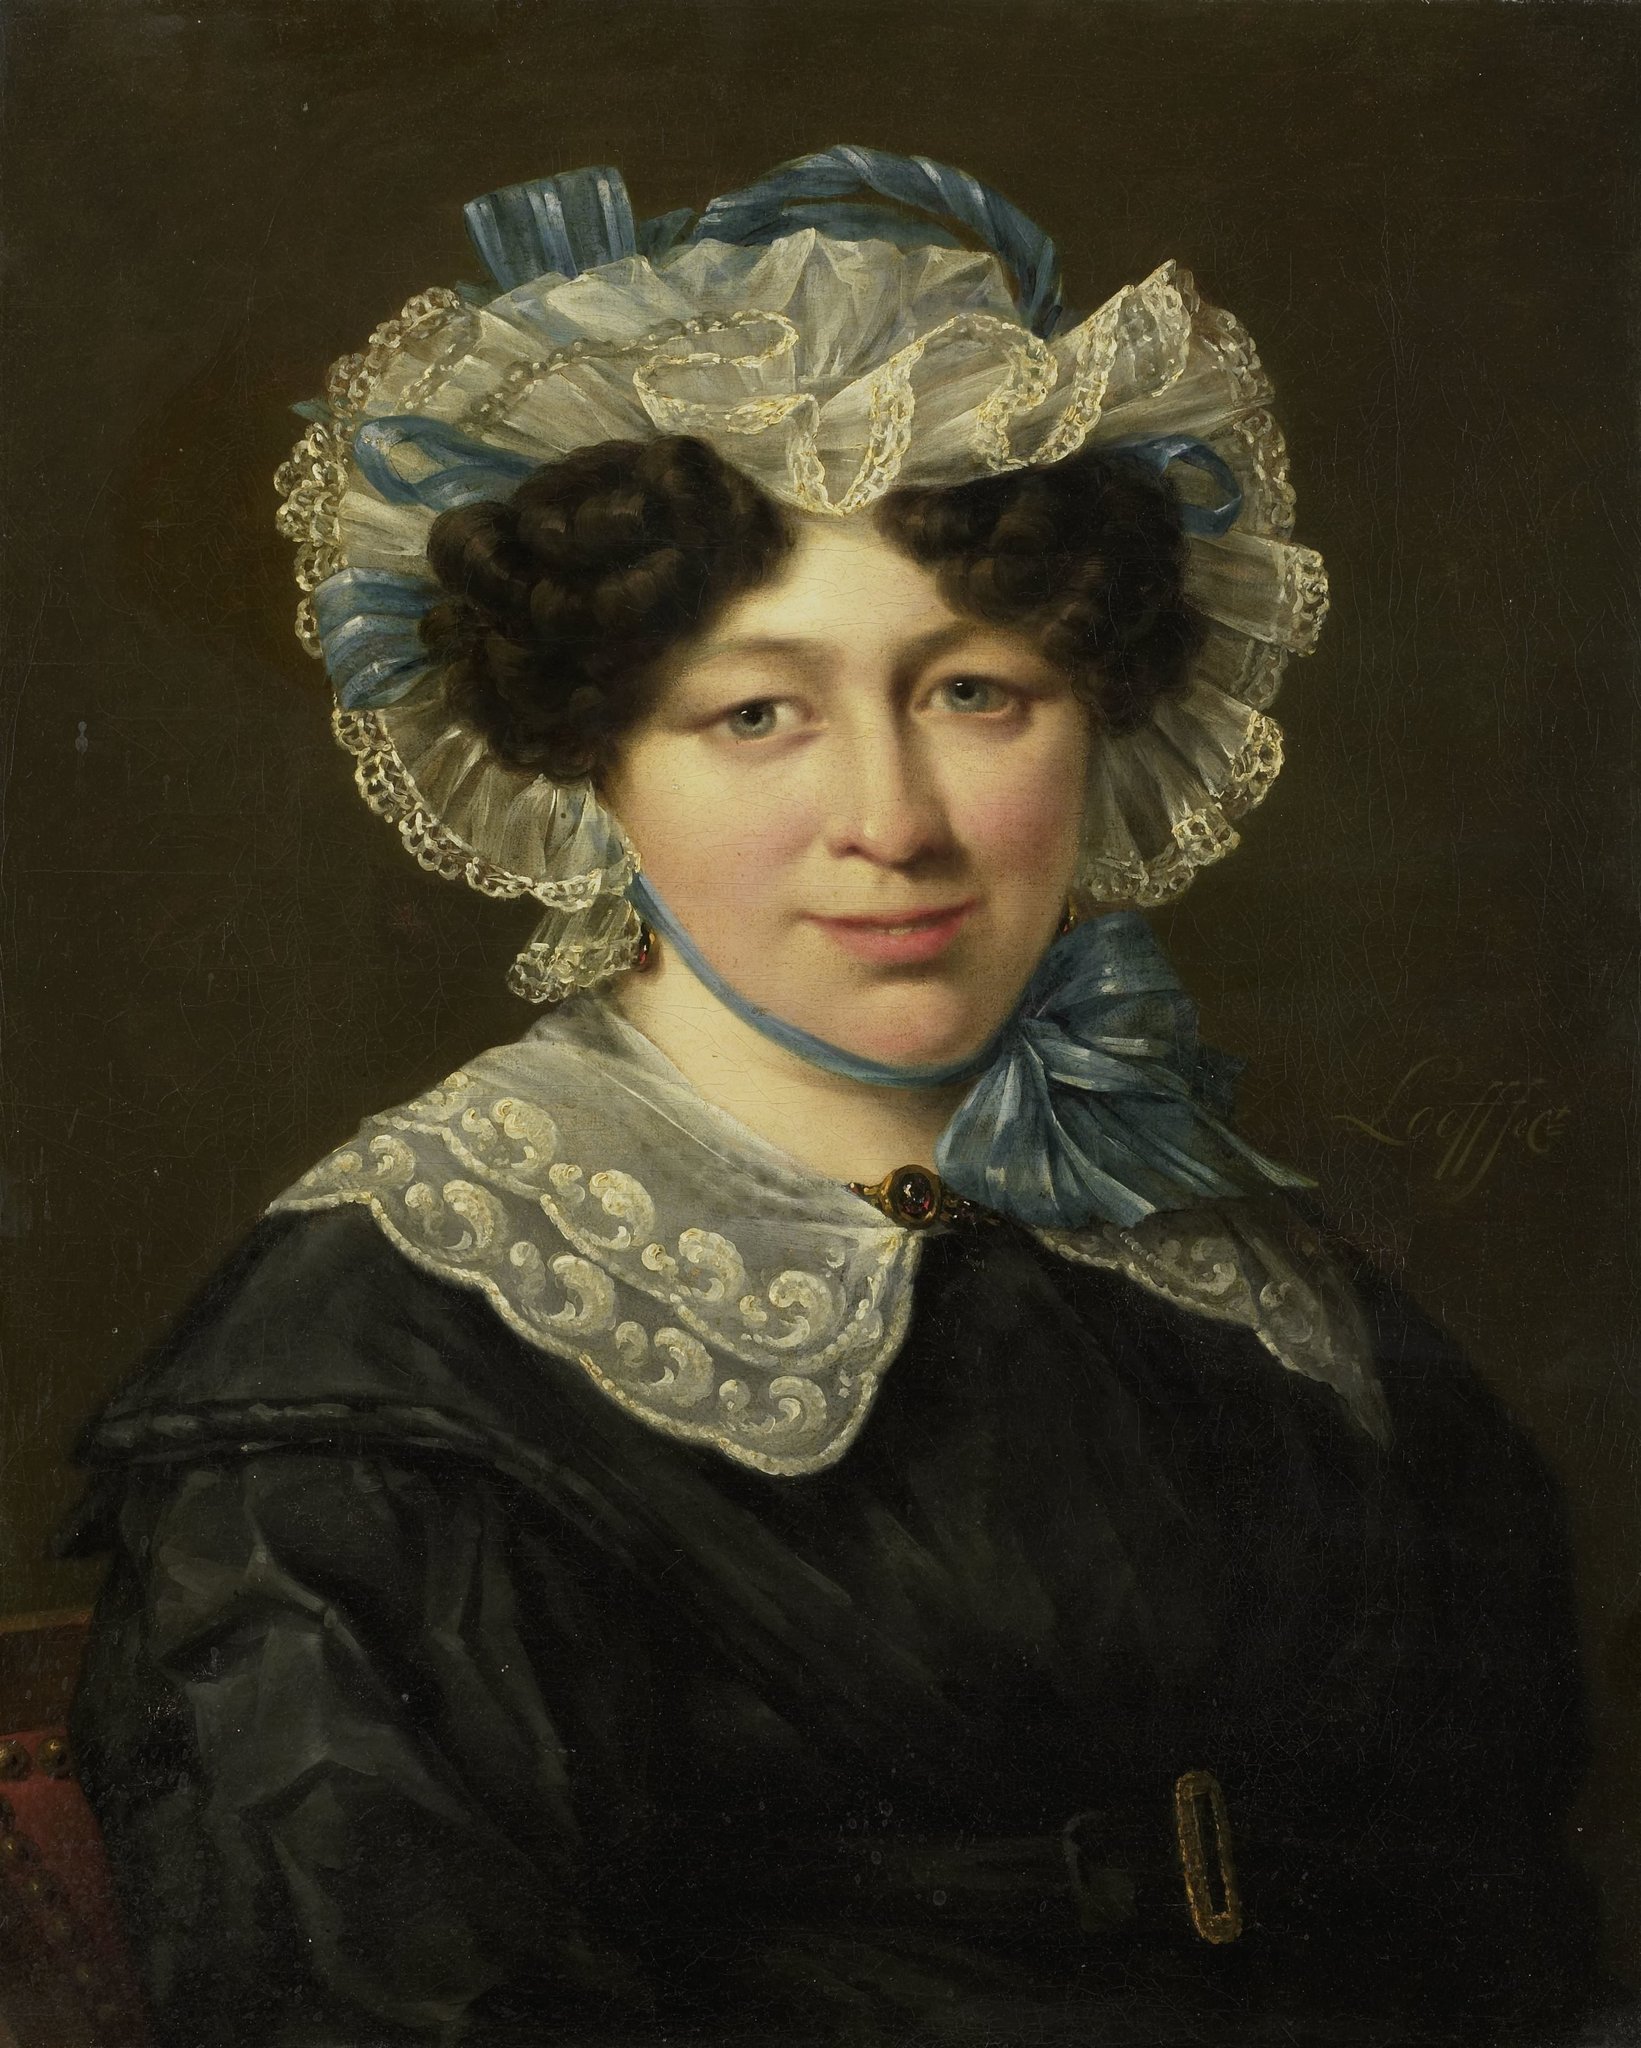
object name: painting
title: Portrait of Maria Adriana van der Sluys, Wife of Hermanus Martinus Eekhout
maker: hillebrand dirk loeff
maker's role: painter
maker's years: 1774-1845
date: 1830-1838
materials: canvas, oil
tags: historical persons - bb - woman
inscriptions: signature: ‘Loeff fec.t’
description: Portret van Maria Adriana van der Sluys, de echtgenote van Hermanus Martinus Eekhout. Buste, naar rechts, met een witte kanten muts op het hoofd. Pendant van SK-A-2791.